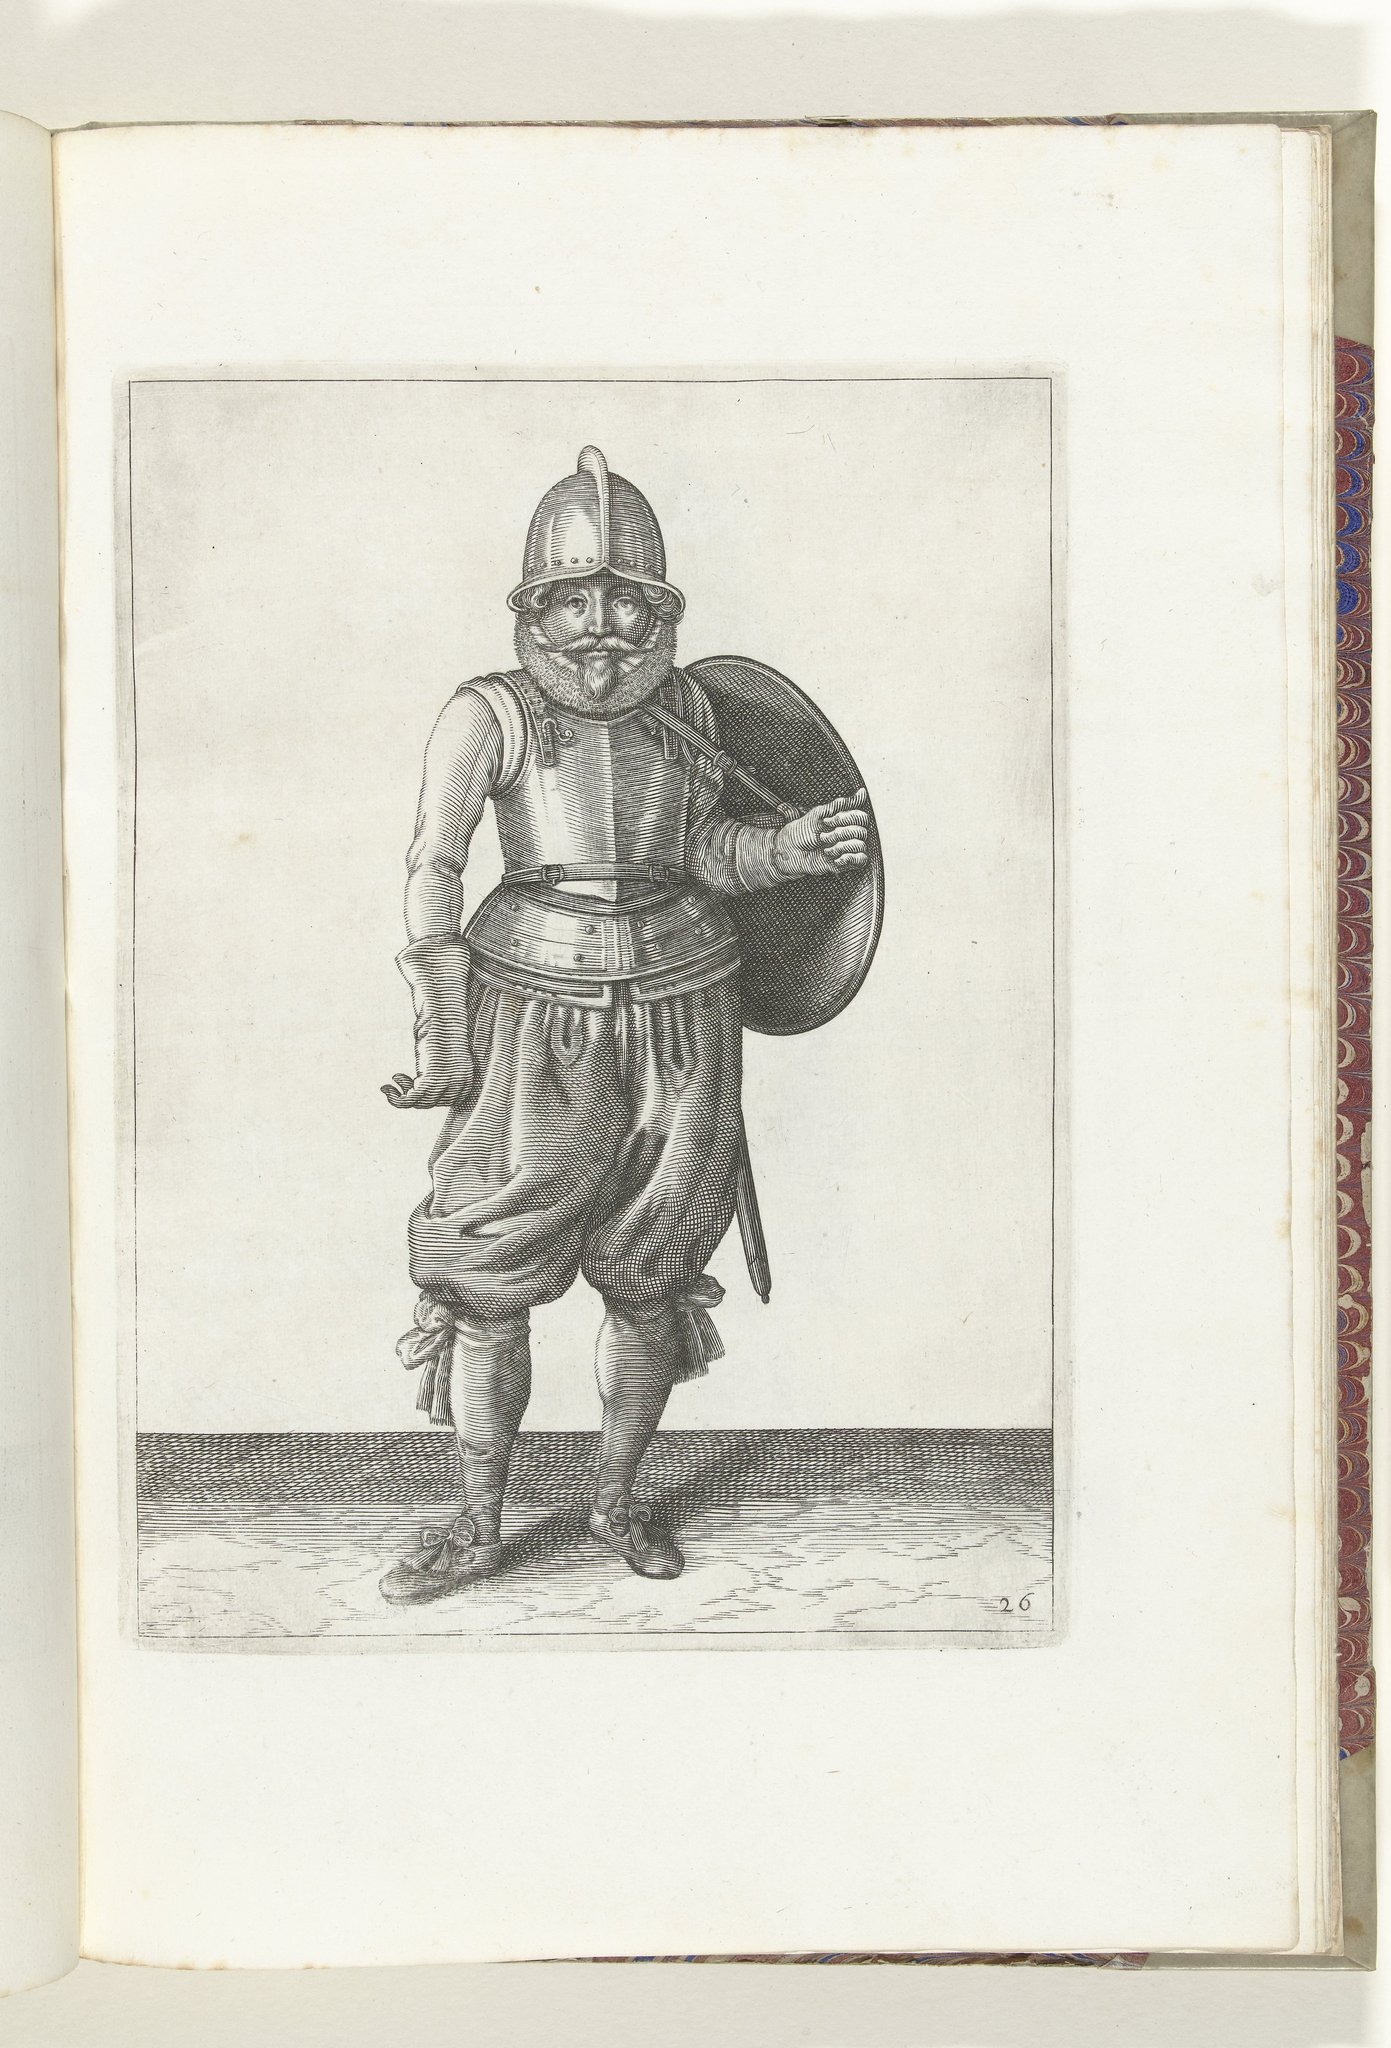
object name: print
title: De exercitie met schild en spies: de soldaat brengt met zijn linkerarm het schild terug op de rug (nr. 26), 1618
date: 1616-1618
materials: paper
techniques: engraving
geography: the hague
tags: maurice (prince of orange), handling of weapons ~ military training, weapons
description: Illustratie in: Adam van Breen, De Nassausche Wapen-Handelinge, van Schilt, Spies, Rappier ende Targe : beyde figuerlick afgebeelt, ende gestelt na de nieu ordening [van] ... Maurits van Nassau, 's-Gravenhage, [Aert Meuris] 1618, plaat nr. 26. In het exemplaar in de collectie van de Rijksmuseum Research Library (326 F 22).